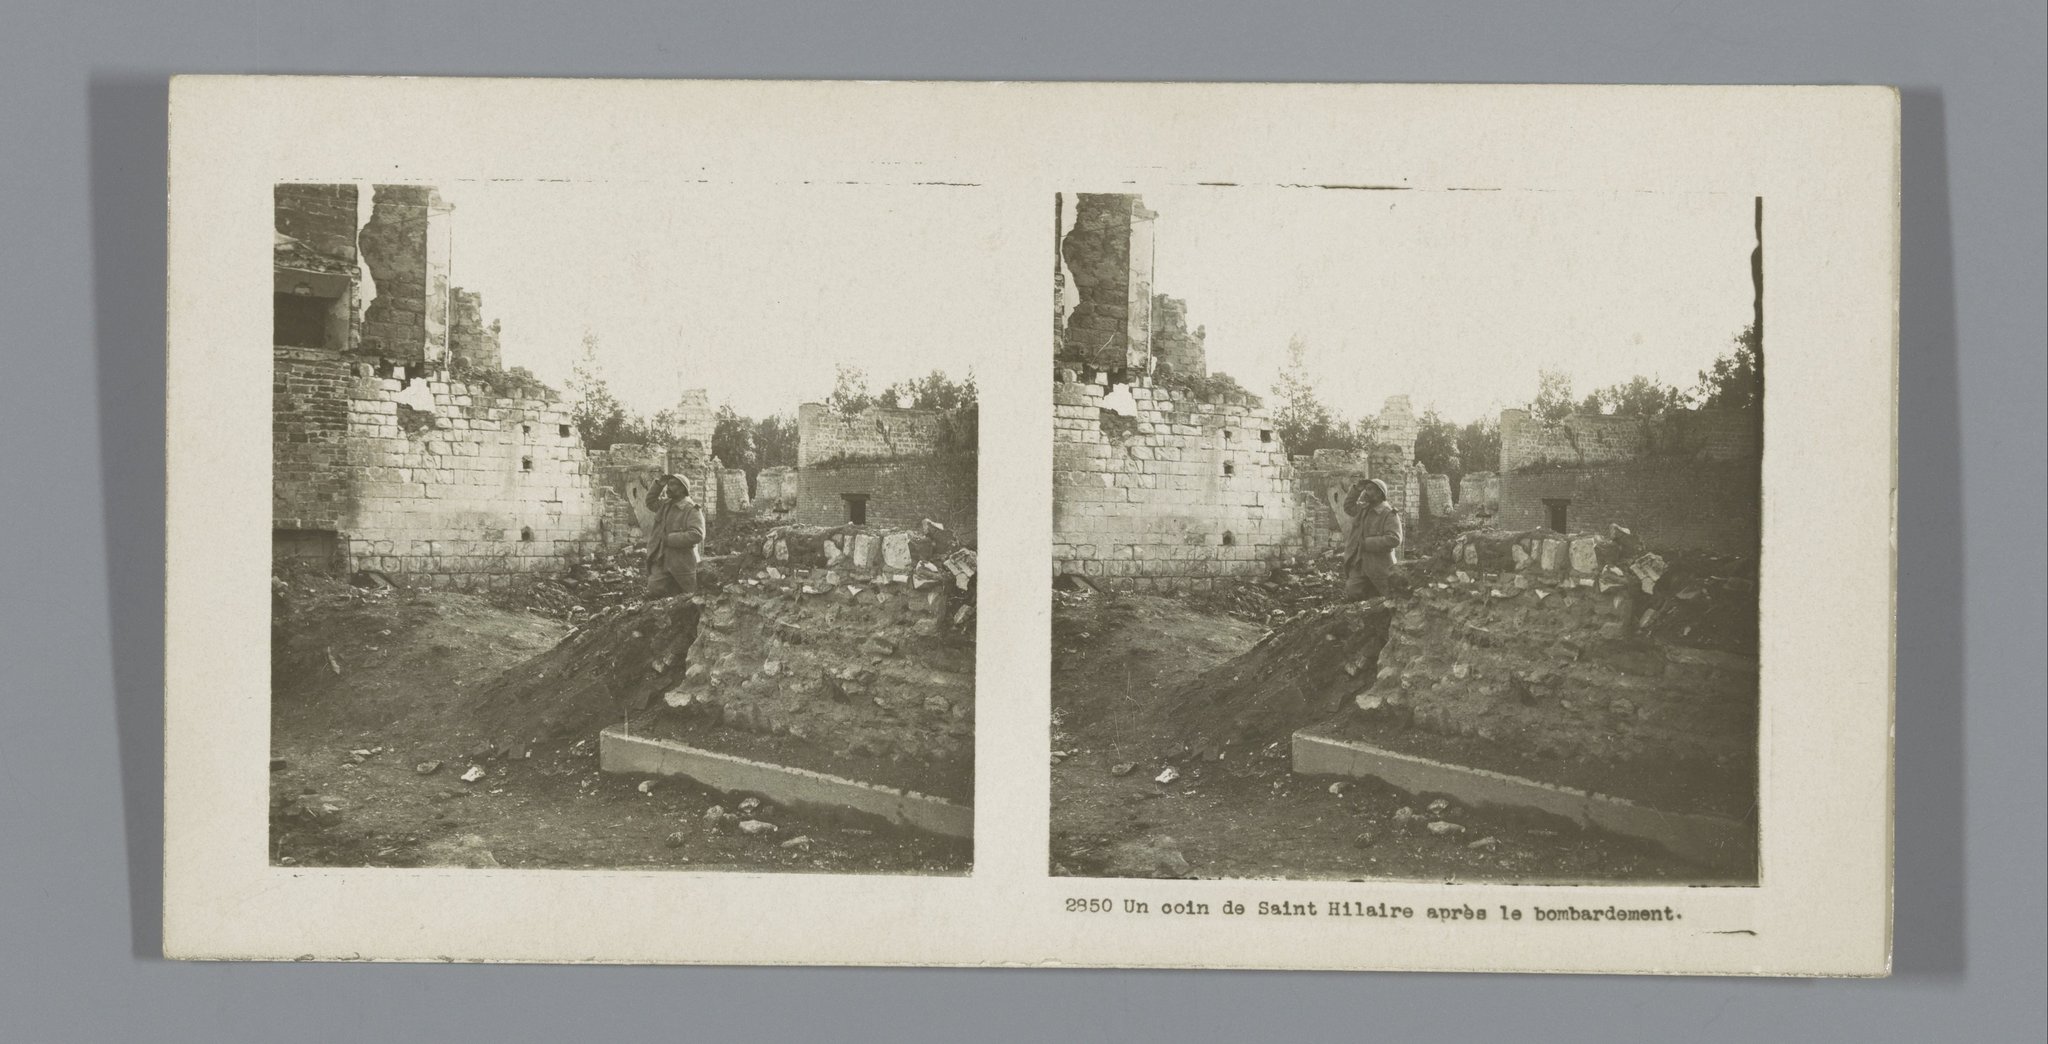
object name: stereograph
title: Soldaat tussen ruïnes te Saint-Hilaire-le-Grand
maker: Anonymous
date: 1914-1918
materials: cardboard, photographic support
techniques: gelatin silver print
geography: saint-hilaire-le-grand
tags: ruin of a building ~ architecture, private soldier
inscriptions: number: ‘2950’